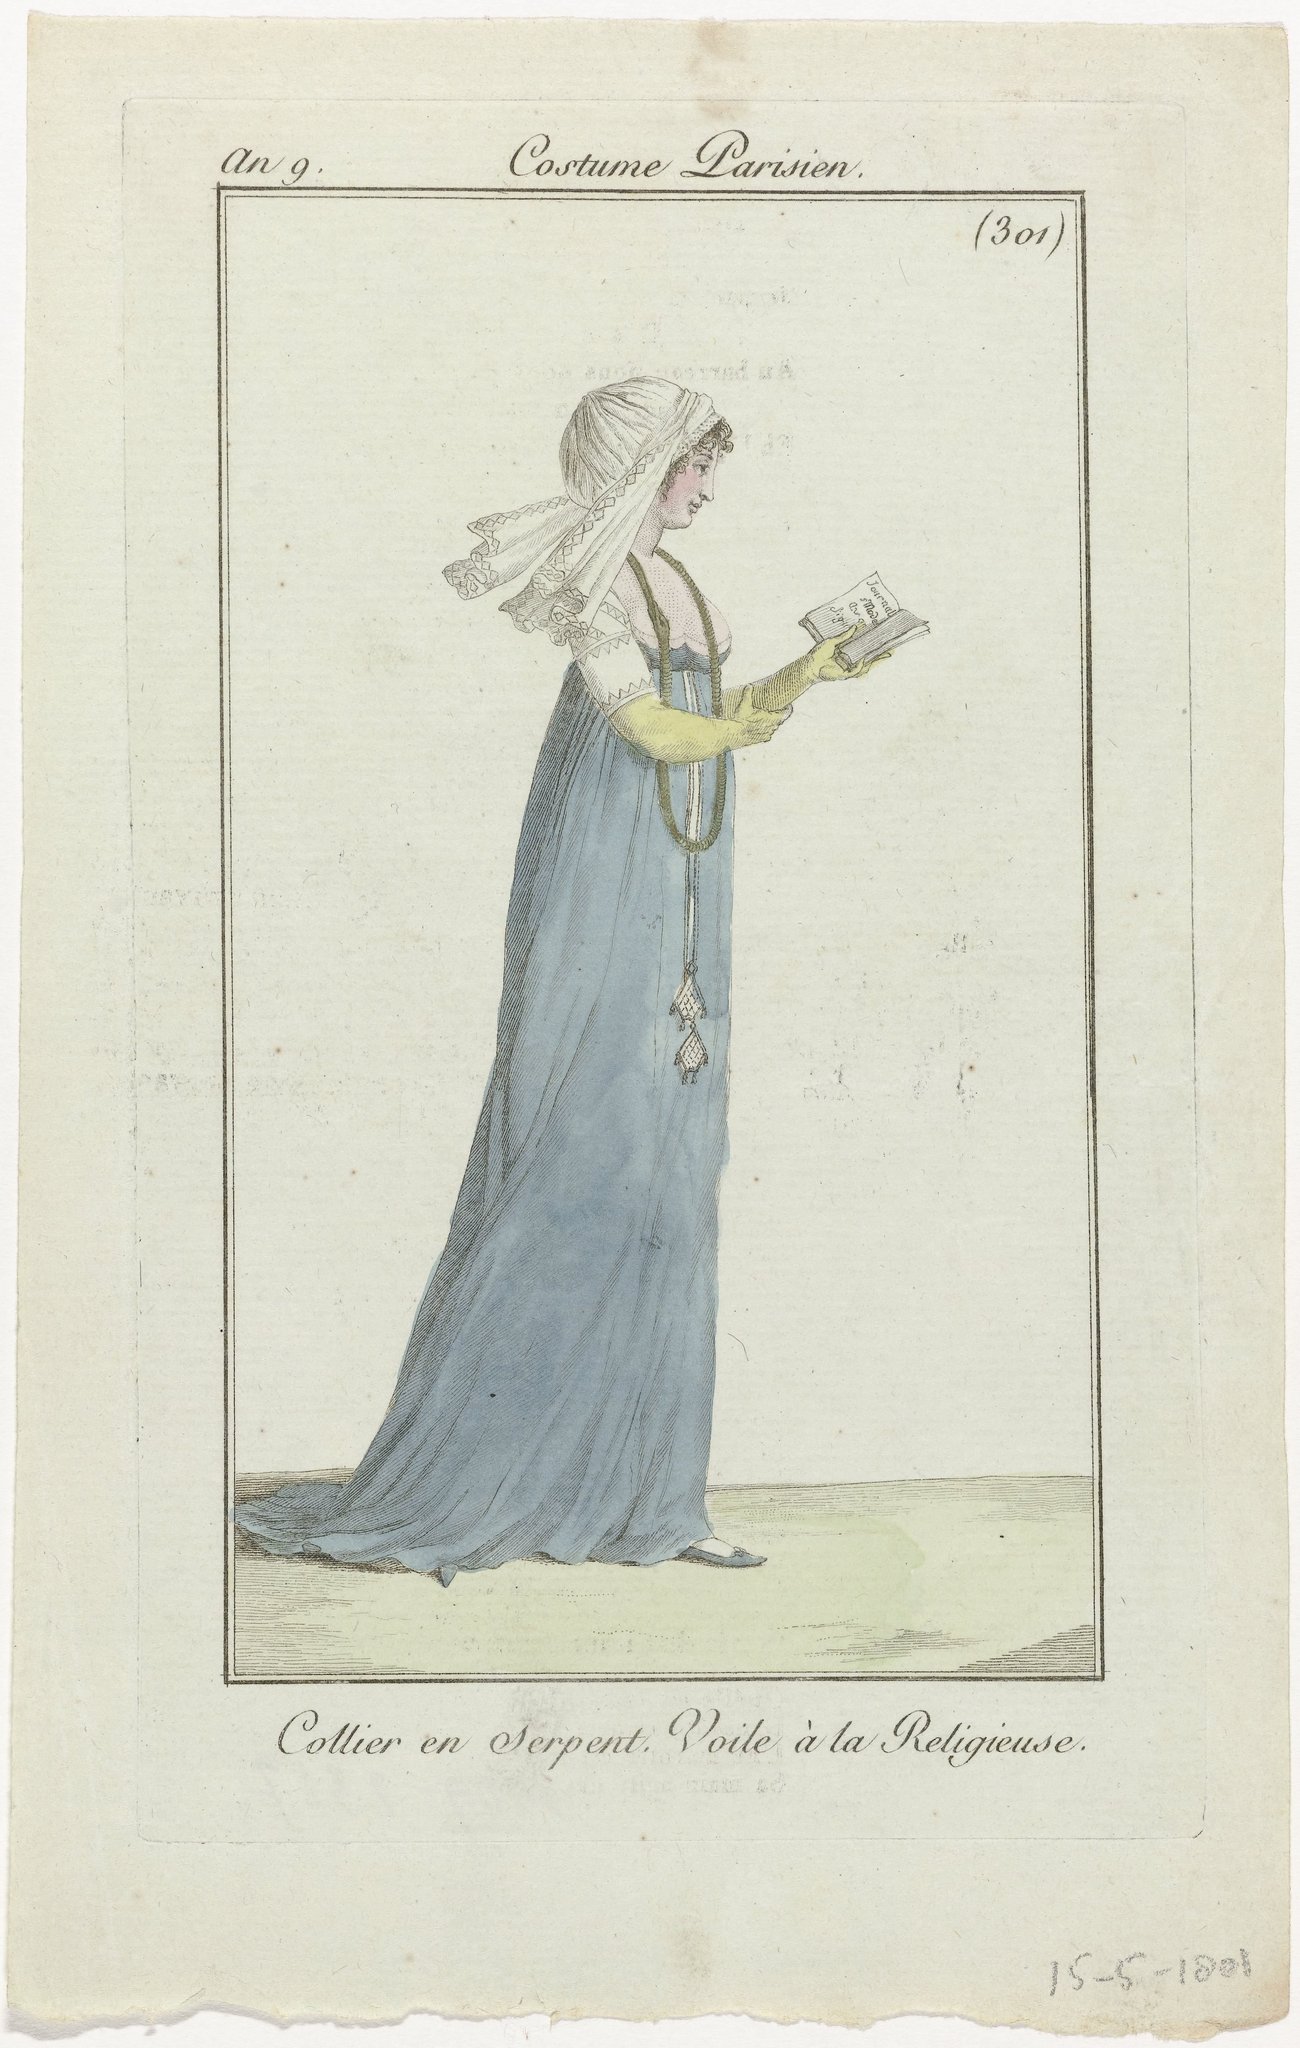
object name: fashion print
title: Collier en Serpent. Voile à la Religieuse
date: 1801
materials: paper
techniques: engraving, hand coloring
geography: paris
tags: veil (+ women's clothes), head-gear (+ women's clothes), fashion plates, dress, gown (+ women's clothes), book - mm - book open, necklace (+ women's clothes)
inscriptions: title: ‘Costume Parisien.’, caption: ‘Collier en Serpent. Voile à la Religieuse.’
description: Between 1797 and 1820 the French Journal des Dames et des Modes was the leading magazine in the area of fashion, accessories, and jewellery. The latest trends were illustrated in hand-coloured prints. The veiled lady shown here wears a gold ouroboros (a serpent eating its own tail) necklace. This symbol of eternal life was already incorporated into jewellery by the ancient Egyptians.